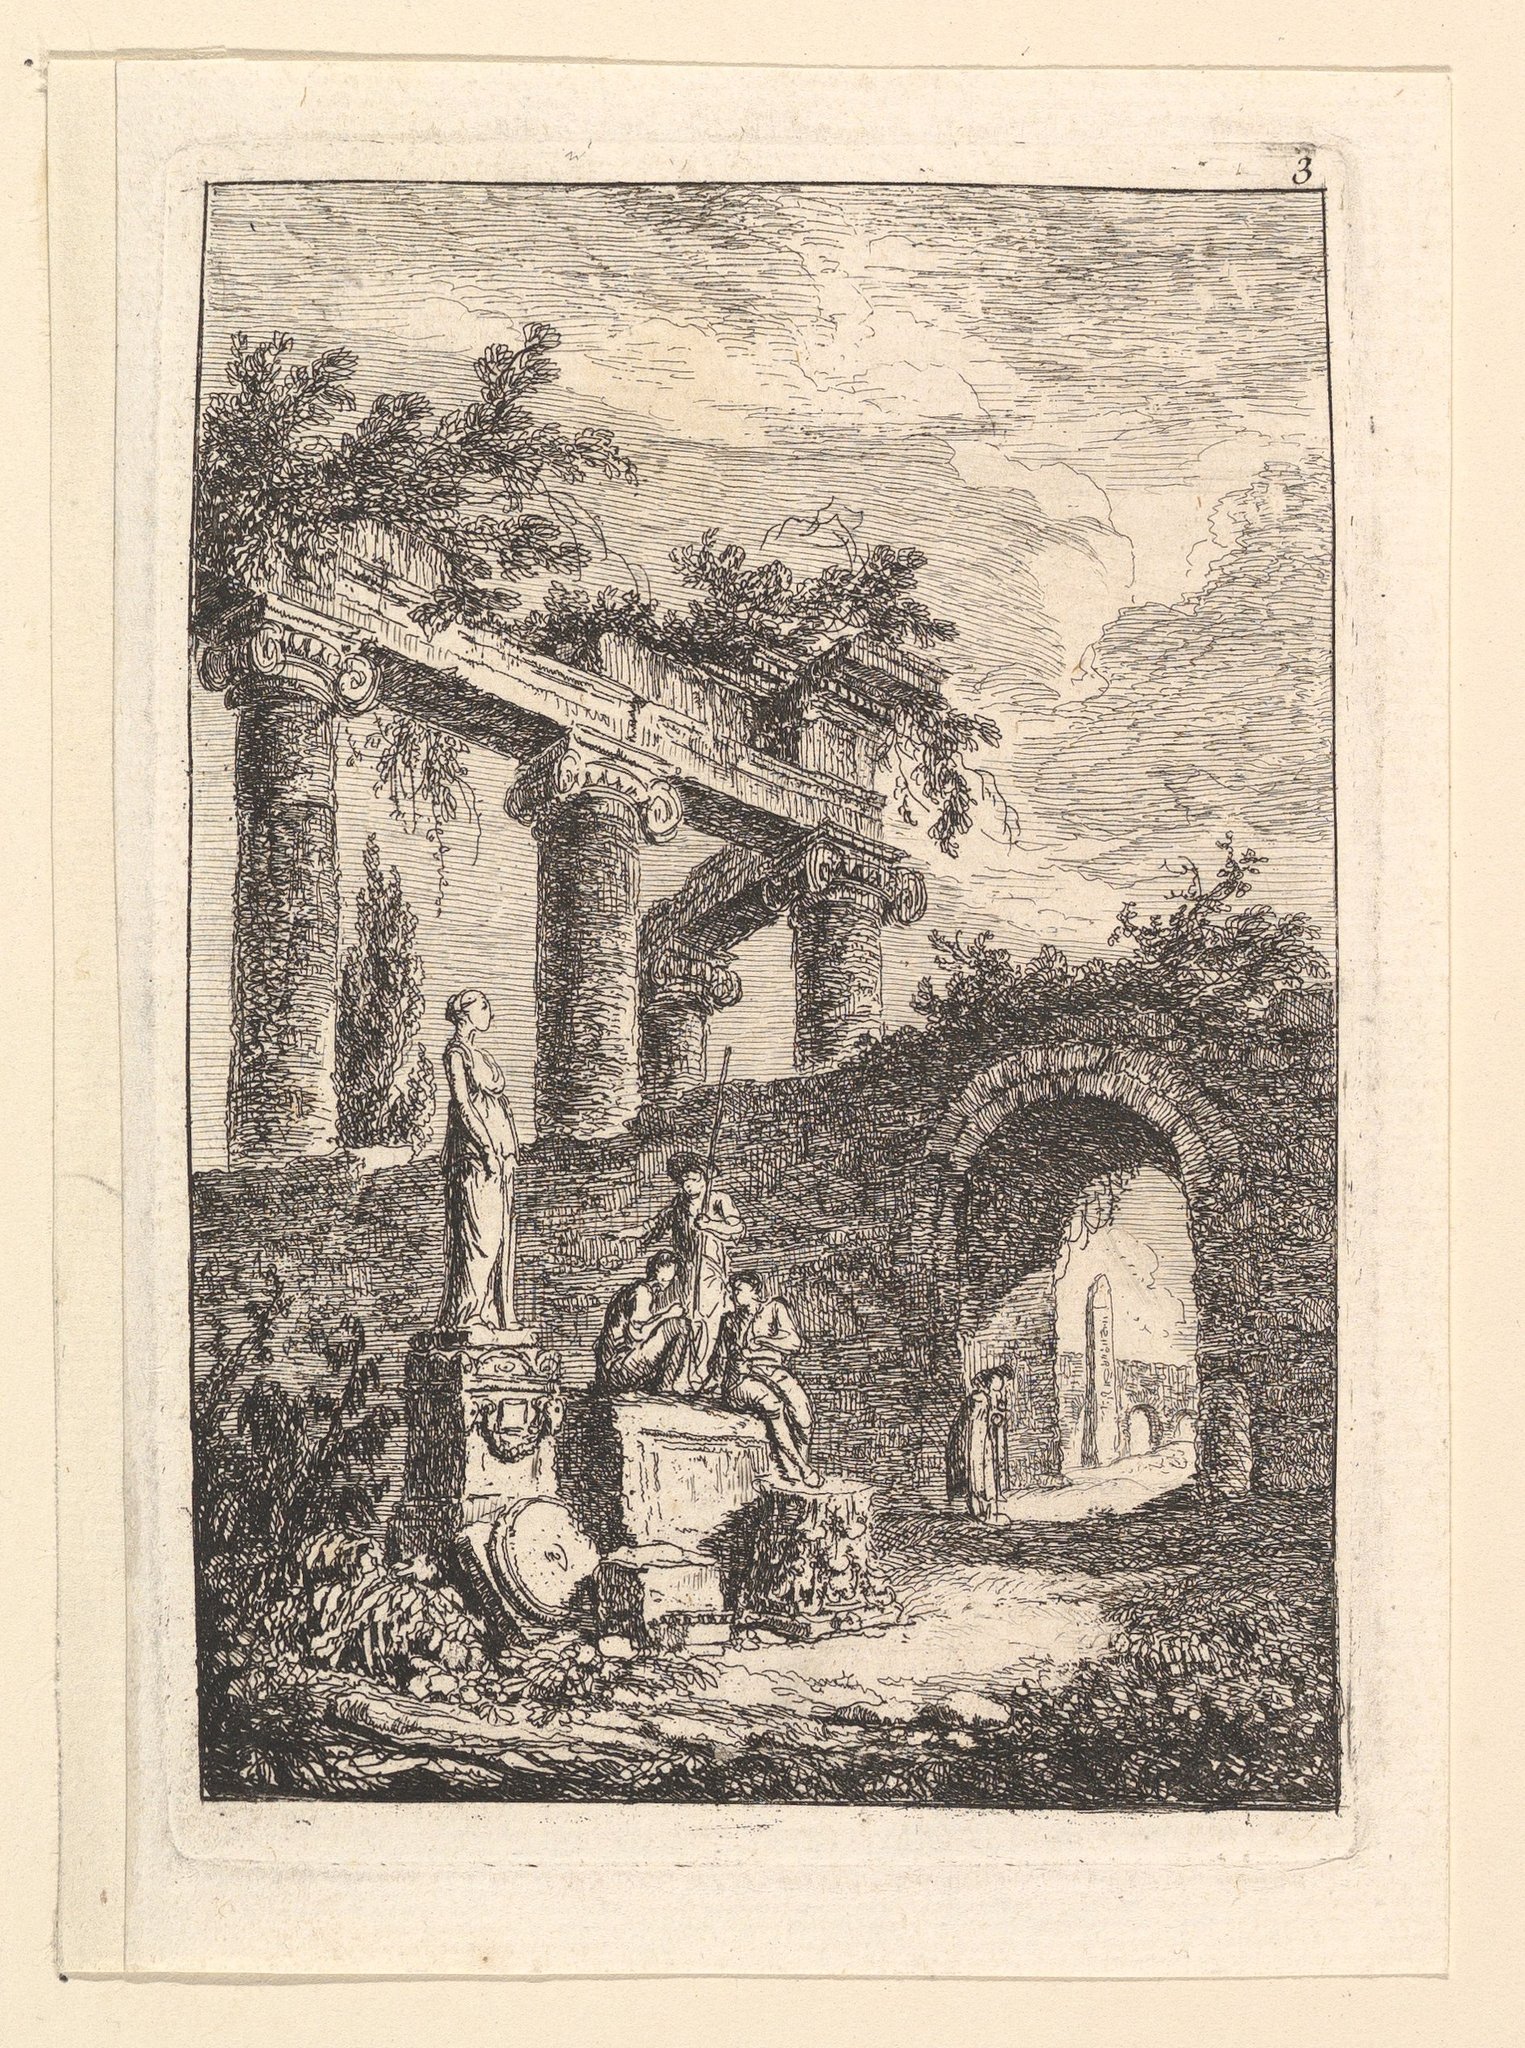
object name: print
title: La Statue en Avant les Ruines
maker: hubert robert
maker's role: artist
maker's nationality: french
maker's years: 1733-1808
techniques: etching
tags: sculpture,ruins